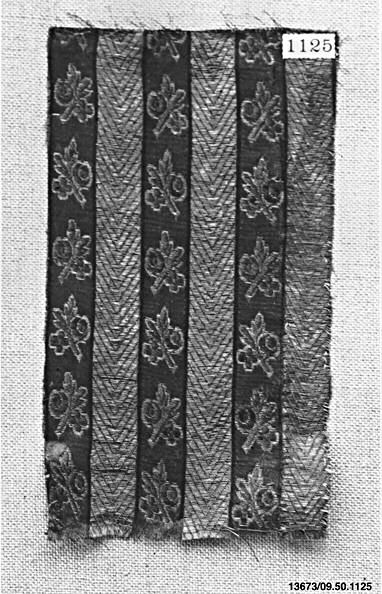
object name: piece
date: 1801-1900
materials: metal thread, silk